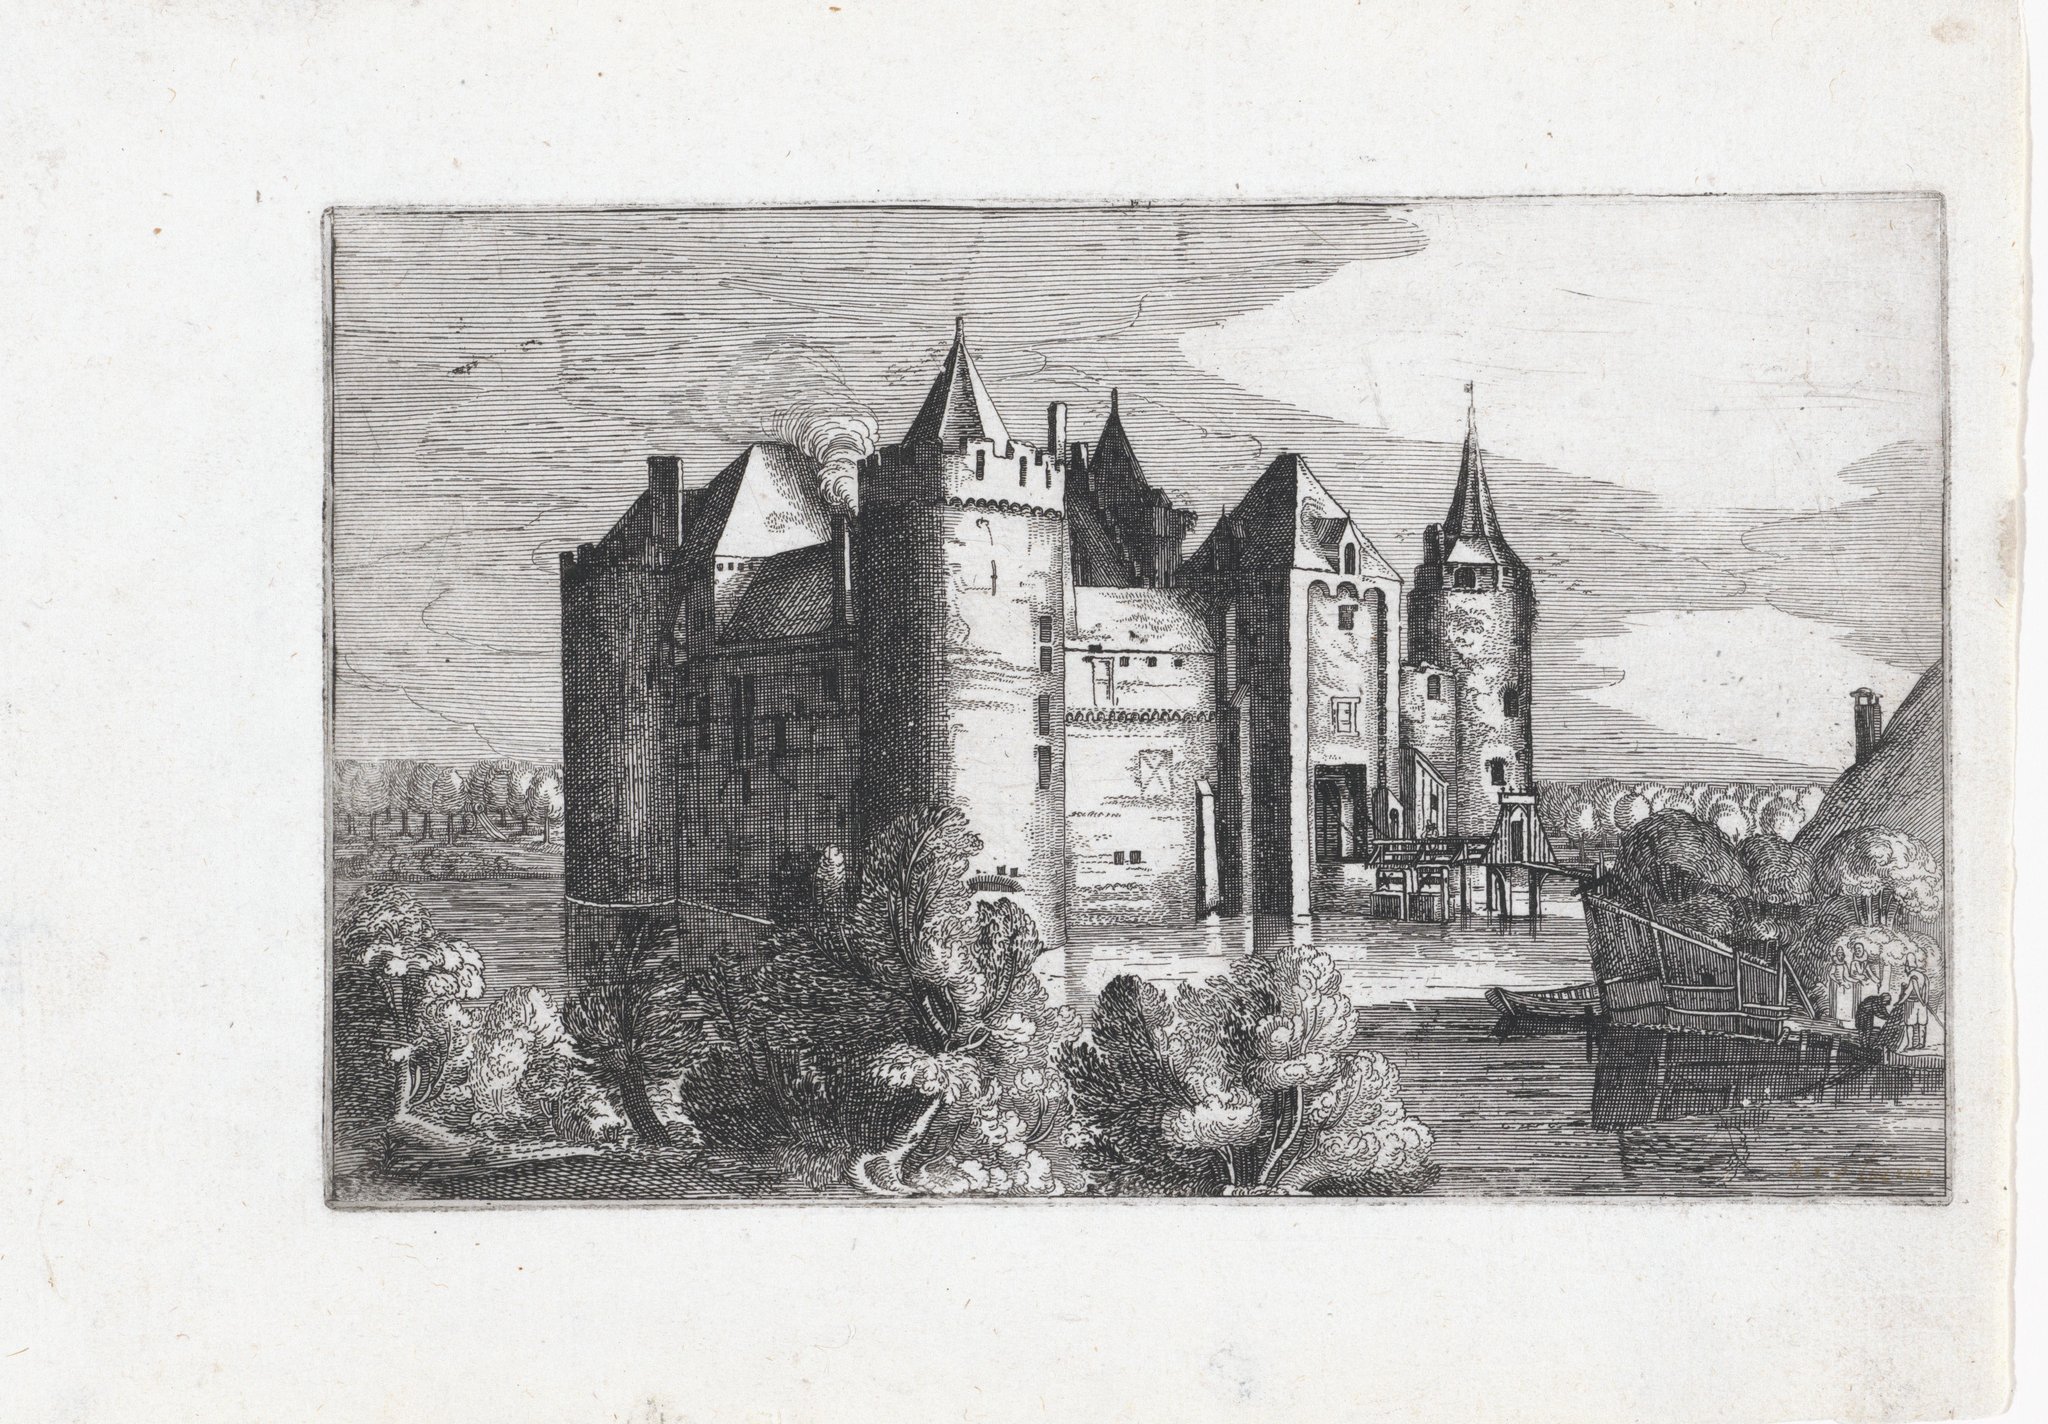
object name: print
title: Slot te Muiden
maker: claes jansz. visscher (ii)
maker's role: draughtsman, print maker, publisher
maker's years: 1586-1652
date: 1596-1630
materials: paper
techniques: etching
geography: amsterdam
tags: drawbridge ~ fortified city, moat ~ fortified city, castle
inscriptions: collector's mark: Lugt 2228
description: Hollstein noemt voor deze reeks verder alleen de afdrukken in Wenen. Deze reeks zou voorafgaan aan de tweede versie (Hollstein 165-168) waarin de kastelen in de juiste richting zijn weergegeven en zijn voorzien van topografische duidingen in het onderschrift.